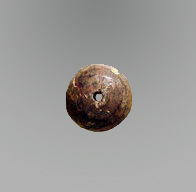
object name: disk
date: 600-401 BCE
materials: amber